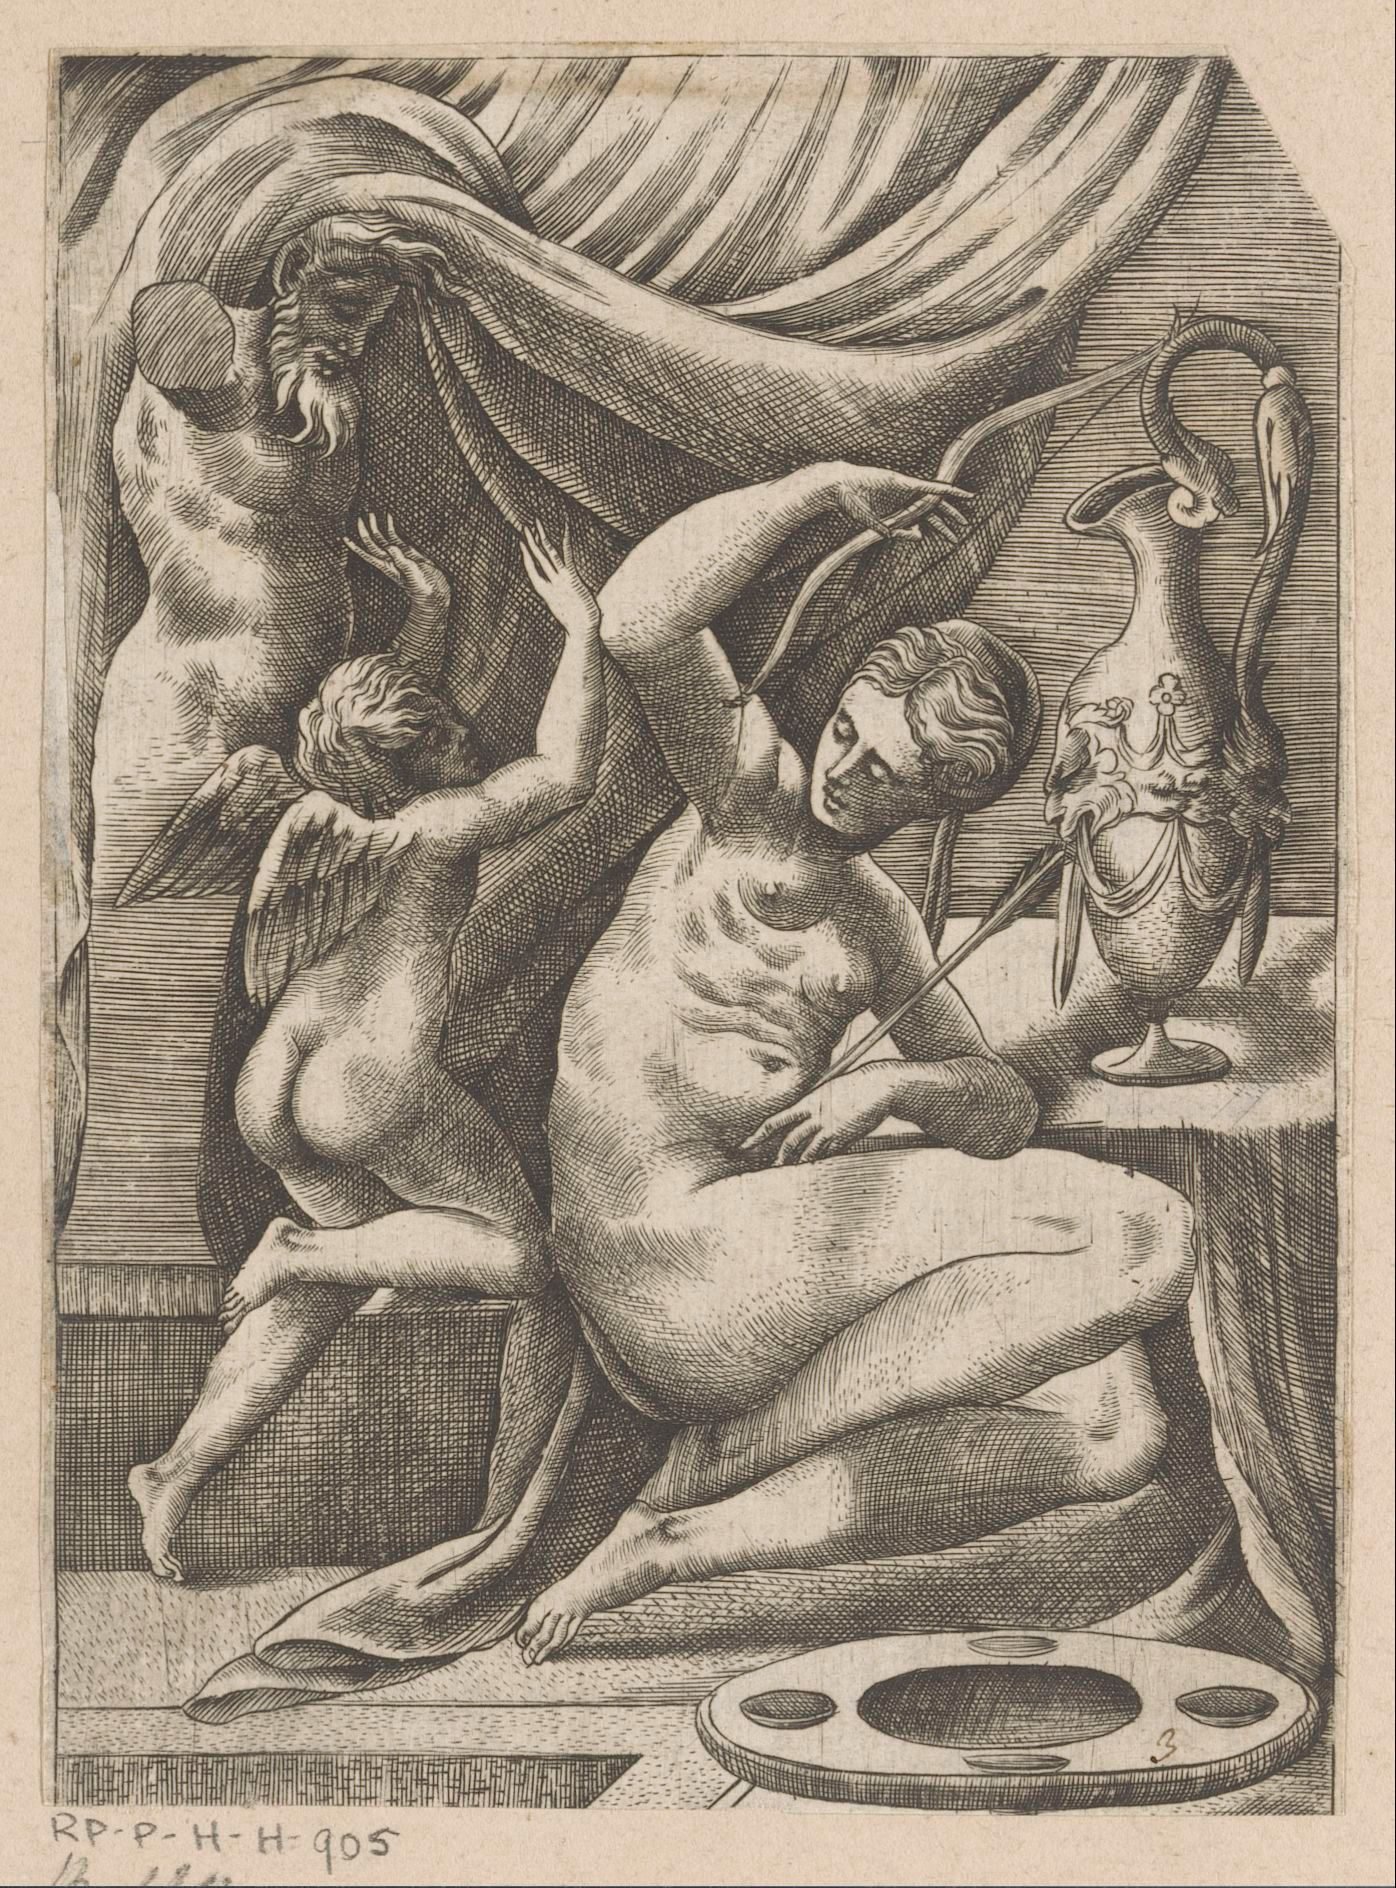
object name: print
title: Venus ontneemt Amor zijn pijl-en-boog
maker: Anonymous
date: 1550-1599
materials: paper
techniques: engraving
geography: italy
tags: herms (garden ornaments), bath of venus, container of ceramics: jar, jug, pot, vase, venus punishing cupid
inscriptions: collector's mark: Lugt 10, number: ‘3’, collector's mark: Lugt 11, collector's mark: ‘Hinloopen’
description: In een interieur zit de naakte Venus op de grond. In haar handen heeft zij de pijl-en-boog van Amor, die naast haar staat. Naast Venus een tafel met een ornamentale schenkkan. Links staat een herme.